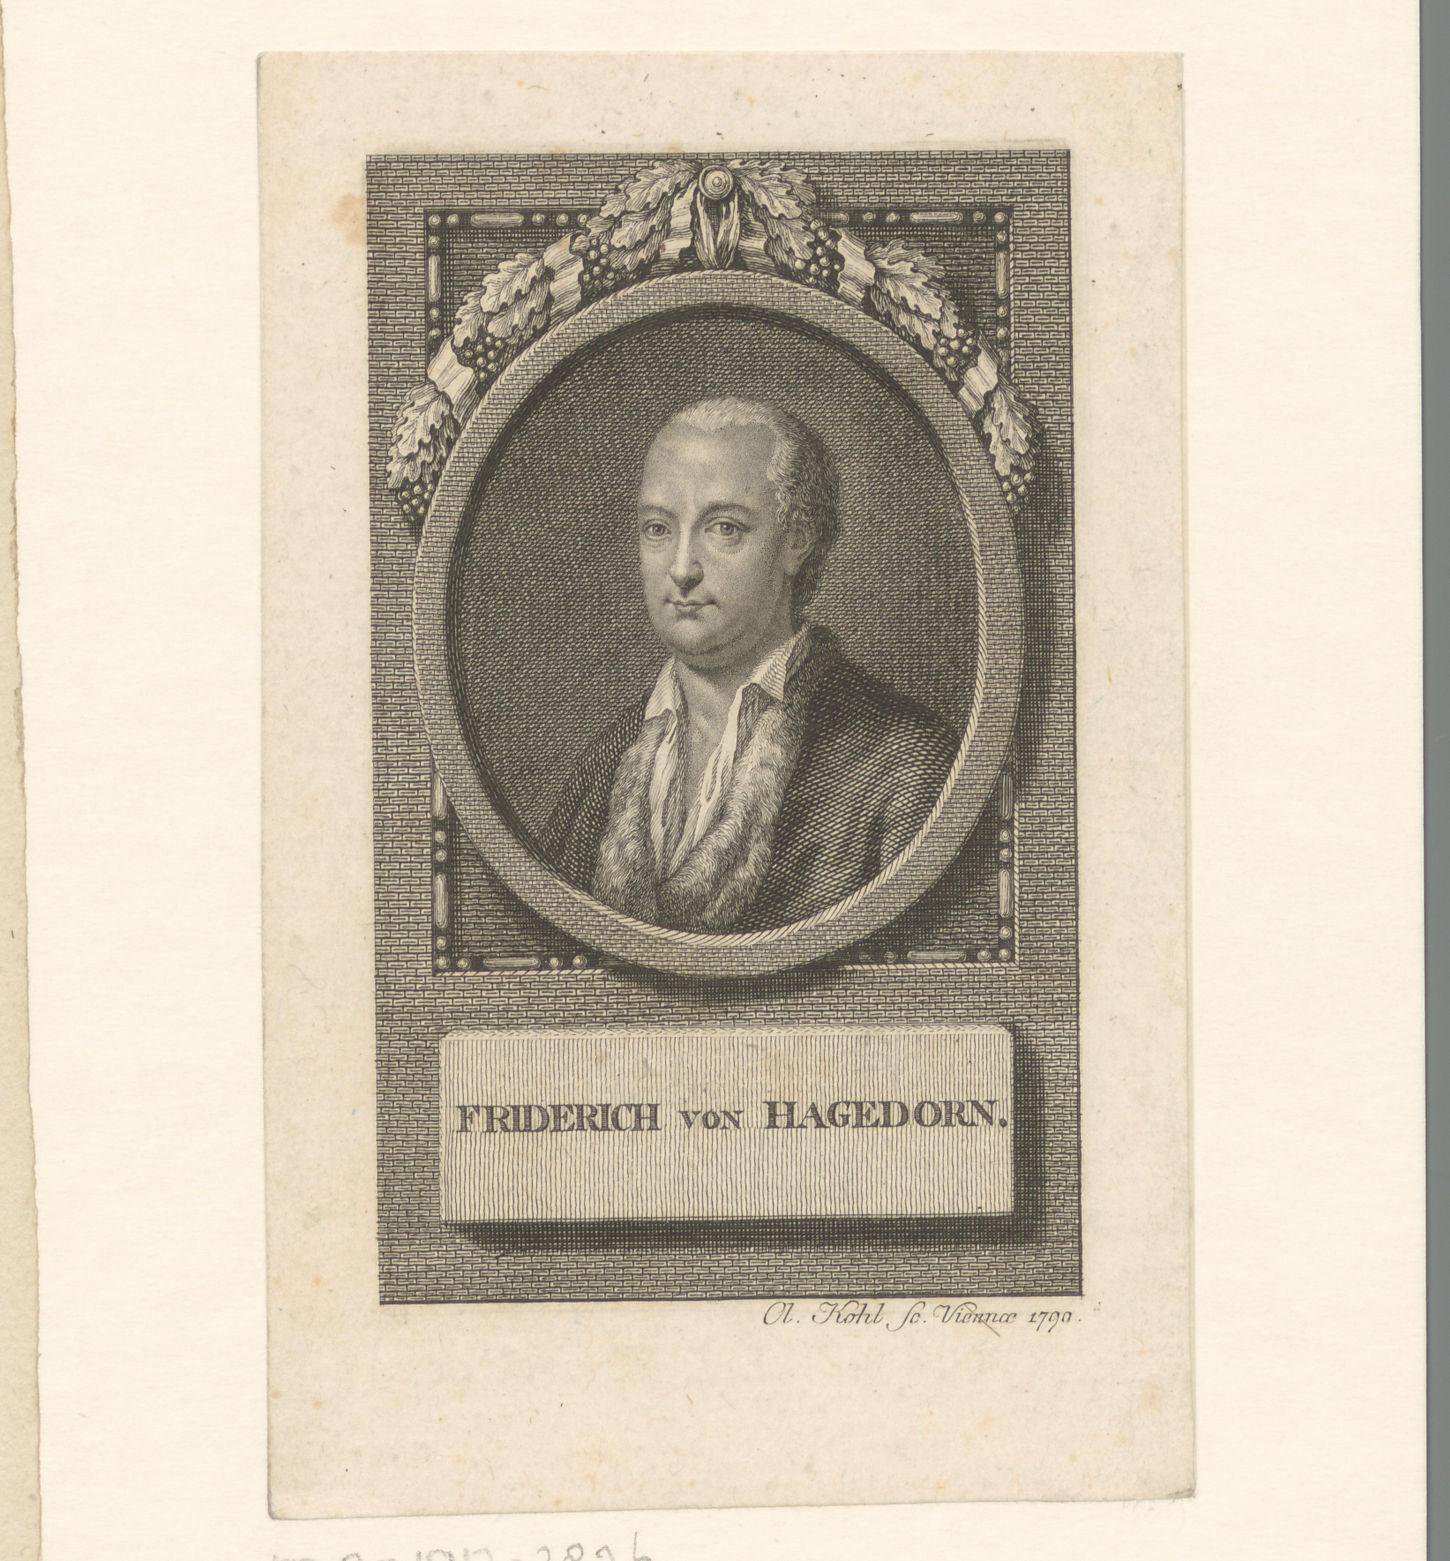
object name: print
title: Portret van Friedrich von Hagedorn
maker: clemens kohl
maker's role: draughtsman, print maker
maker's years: 1754-1807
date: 1790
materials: paper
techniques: engraving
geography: vienna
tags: historical persons, writer, poet, author, ornament ~ festoon, garland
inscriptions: collector's mark: Lugt 2228